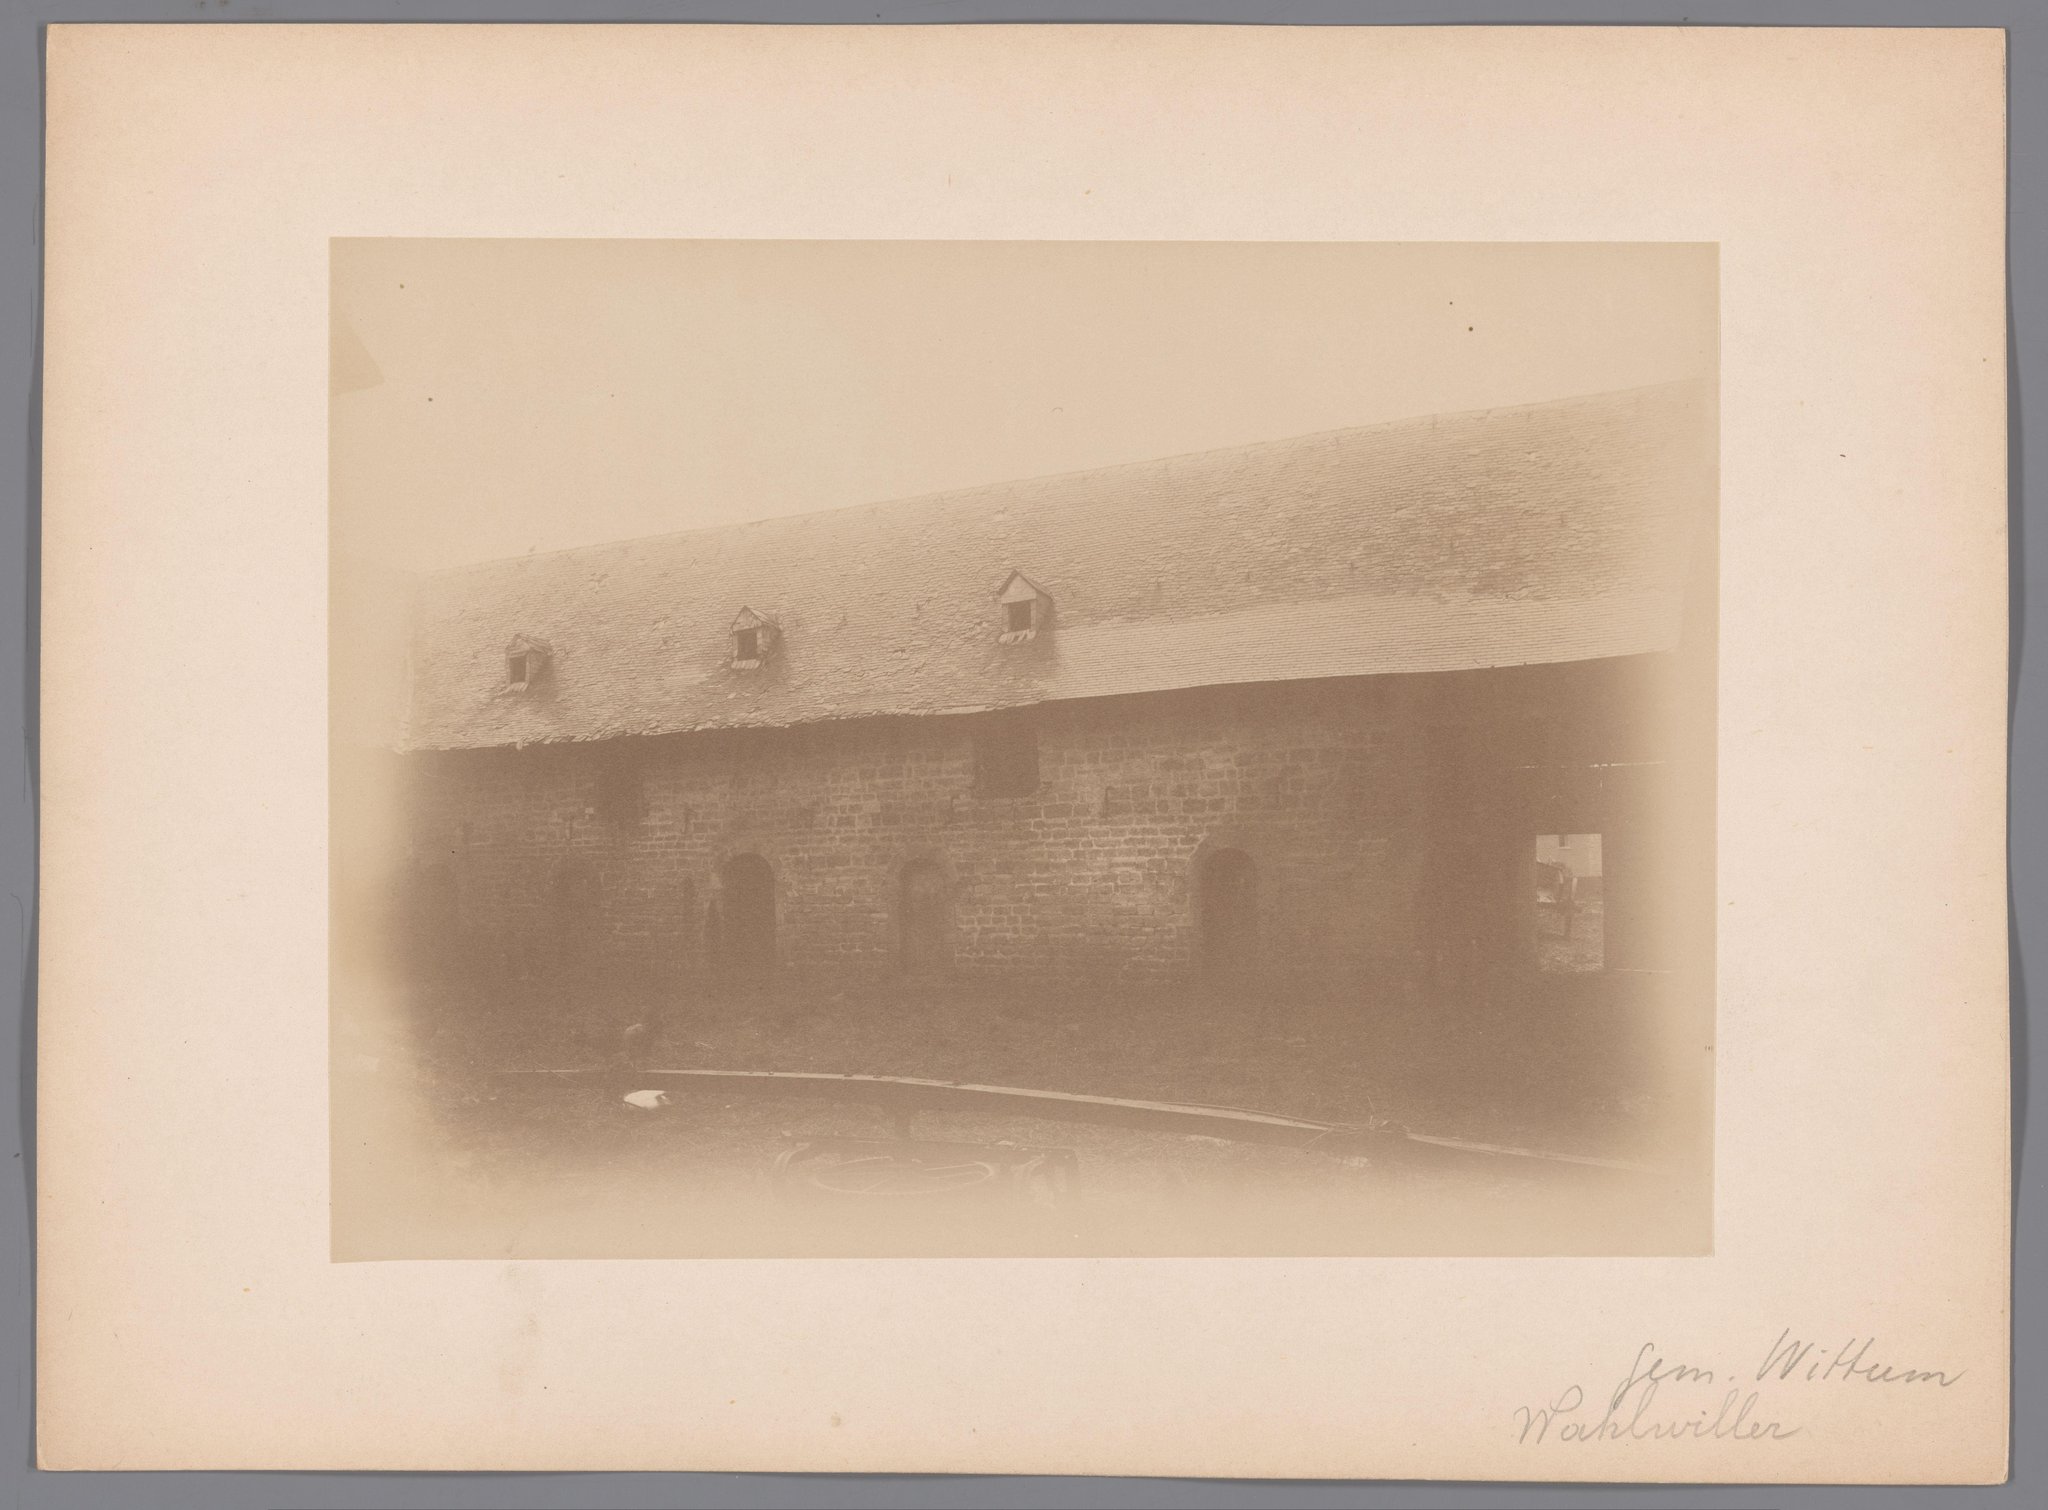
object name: photograph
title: Gedeelte van boerderij Leyenhof te Wahlwiller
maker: anoniem (monumentenzorg)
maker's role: fotograaf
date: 1890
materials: cardboard, photographic support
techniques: albumen print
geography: wahlwiller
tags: farm (building)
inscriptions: annotation: ‘Gem. Wittum/ Wahlwiller’, annotation: ‘De boerderij Leyenhof te Wahlwiller/ geph. - 25 oct 1890 afgebrand 31 oct 1890’